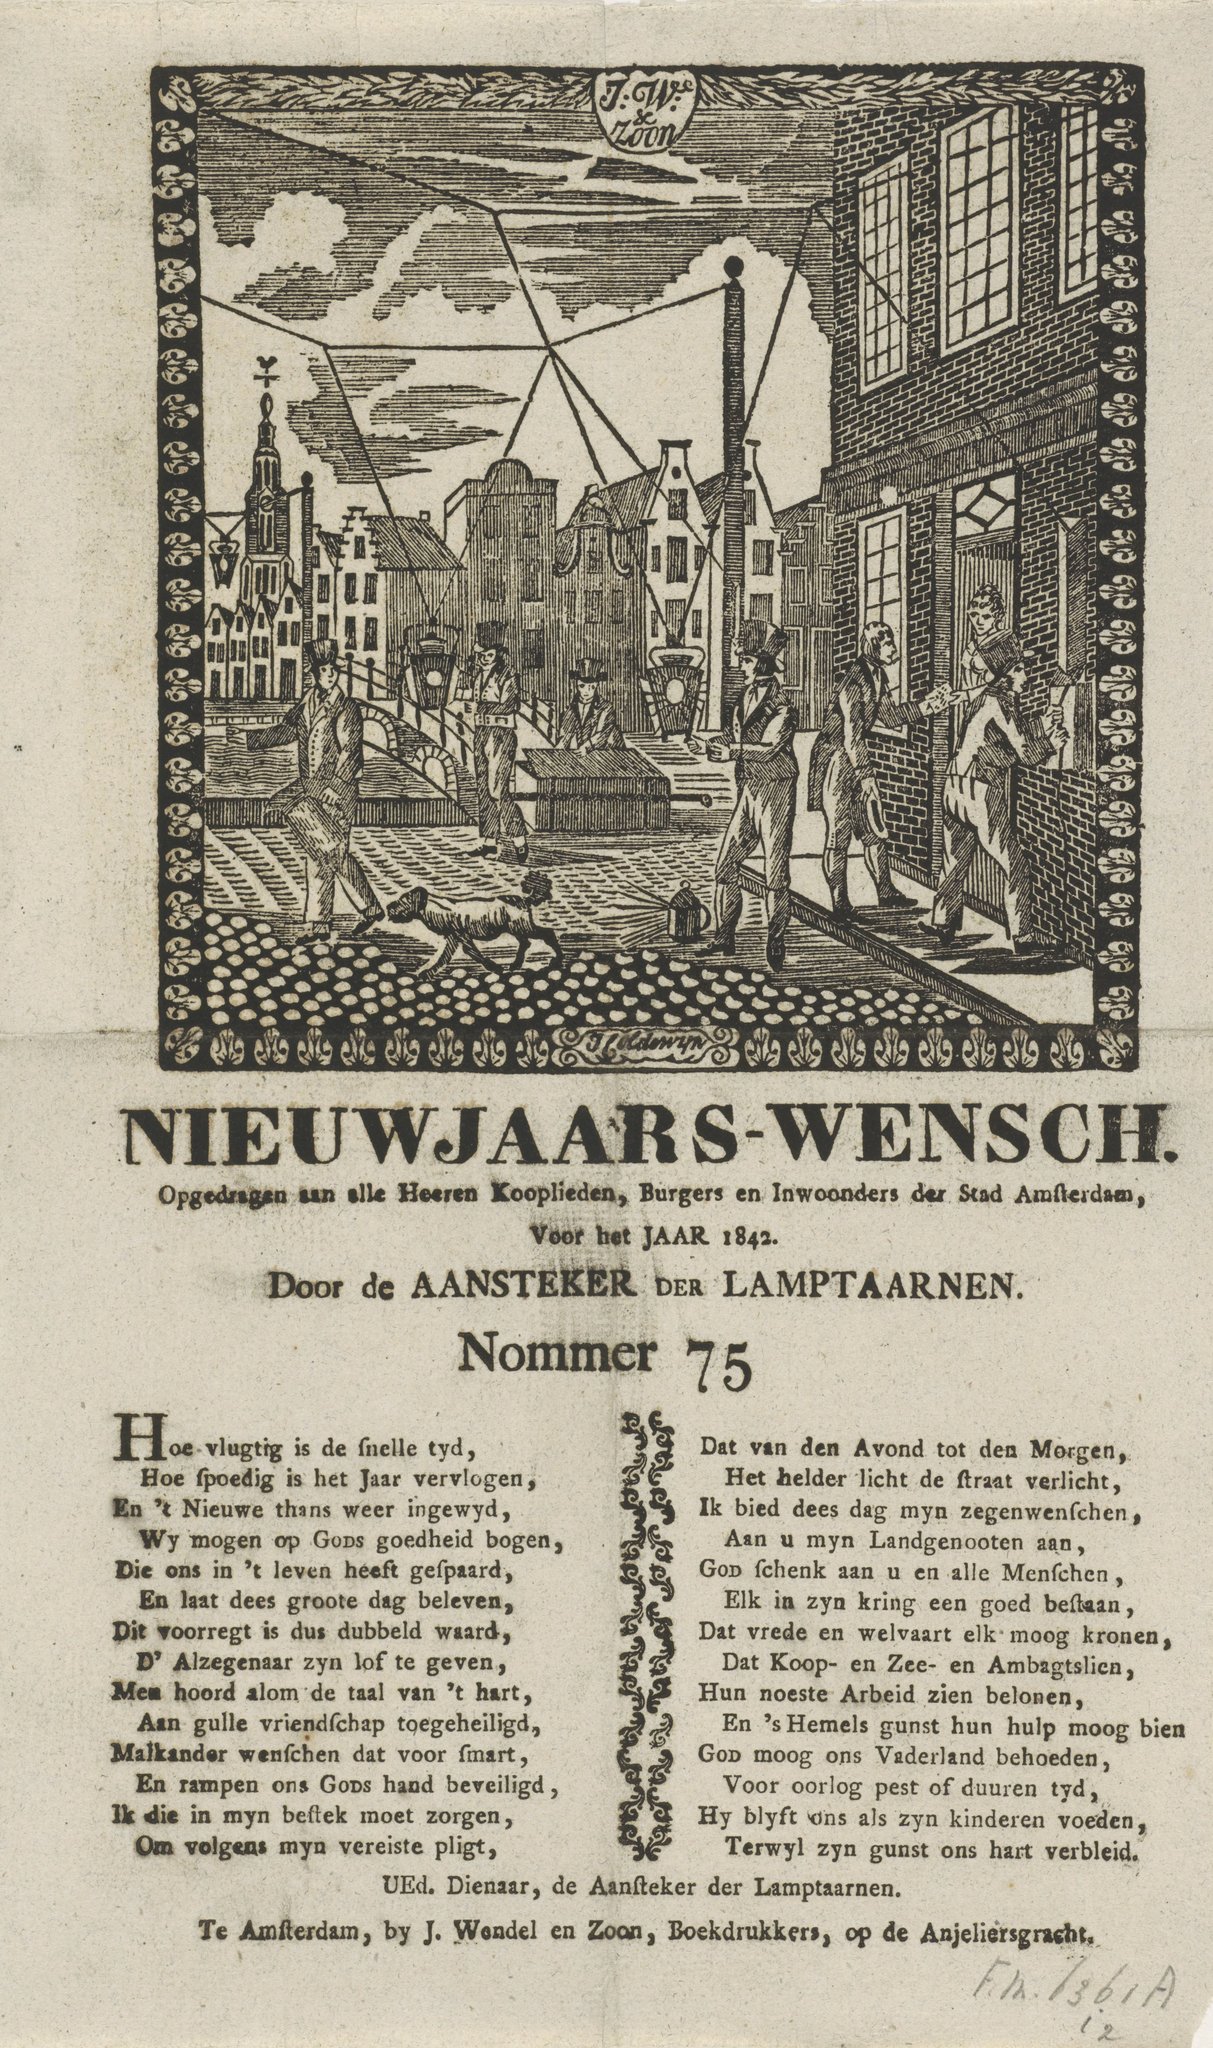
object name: new year card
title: Nieuwjaarswens van de lantaarnopstekers van Amsterdam voor het jaar 1842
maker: jacob coldewijn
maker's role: print maker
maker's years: 1796-1855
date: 1841-1842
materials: paper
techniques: letterpress printing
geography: amsterdam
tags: oil-lamp (+ kindling a light; lit, burning light, lamp, candle), street lighting, street, amsterdam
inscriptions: collector's mark: Lugt 2228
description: Nieuwjaarswens van de Amsterdamse lantaarnopstekers en vullers voor het jaar 1842. Gezicht in een straat in Amsterdam waar enkele mannen bezig zijn de straatlantaarns te vullen en aan te steken. Een andere man haalt geld op bij een huis. Met gedicht in twee kolommen. Van de lantaarnopstekers in de wijk no. 75.